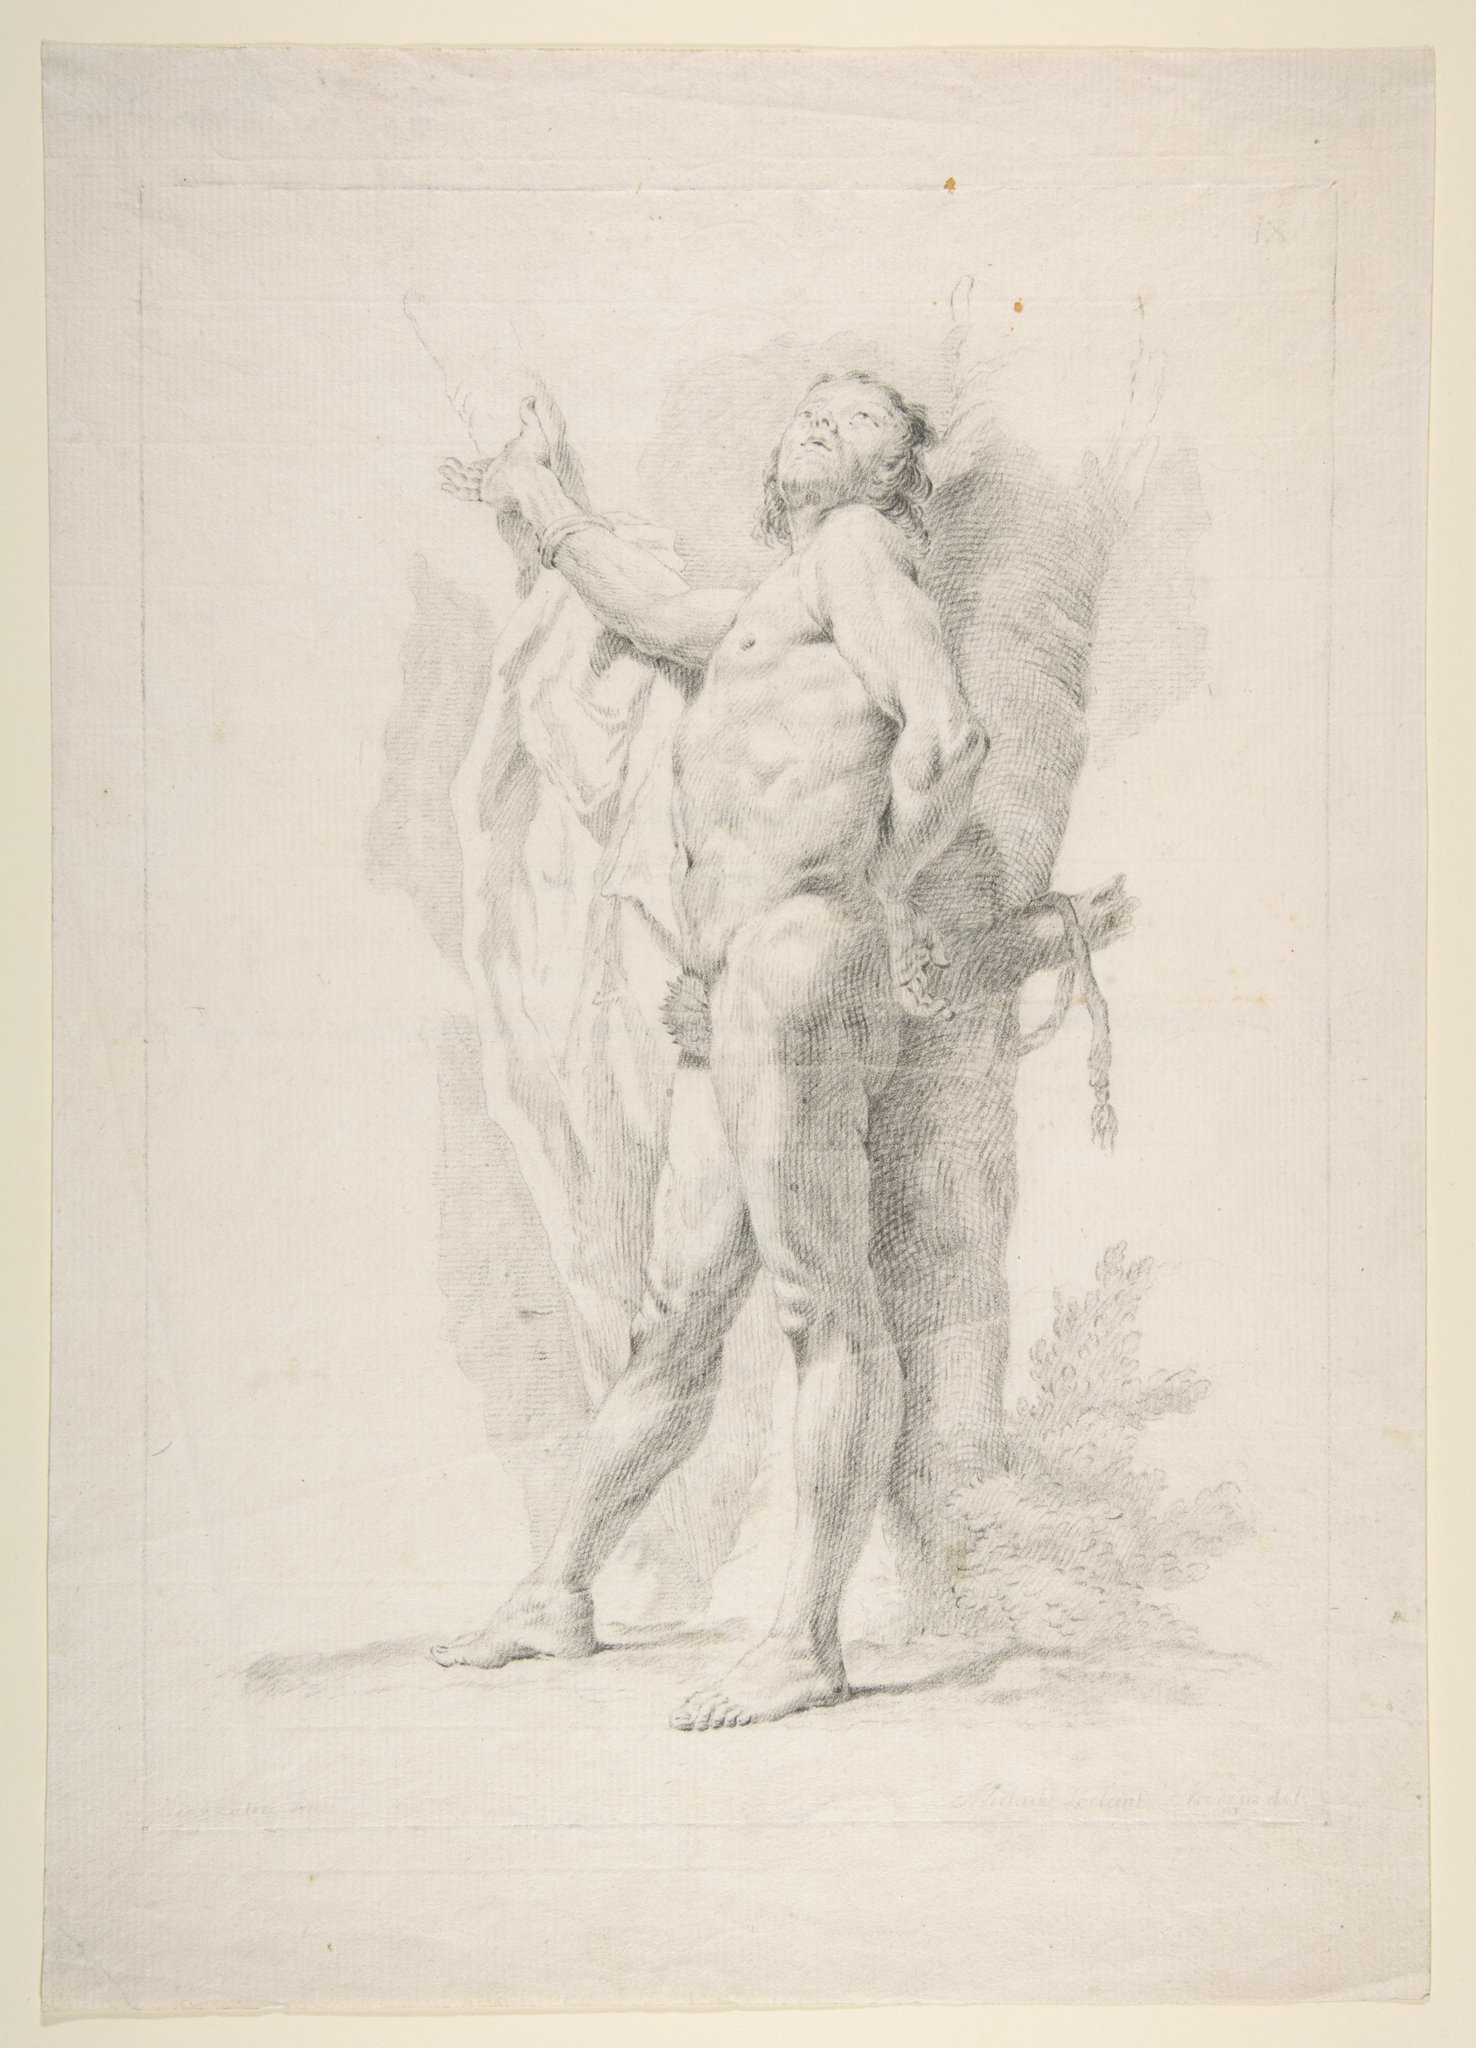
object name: drawing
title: Nude Figure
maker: giovanni battista piazzetta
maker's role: artist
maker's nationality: italian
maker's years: 1682-1754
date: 1720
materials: chalk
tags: male nudes